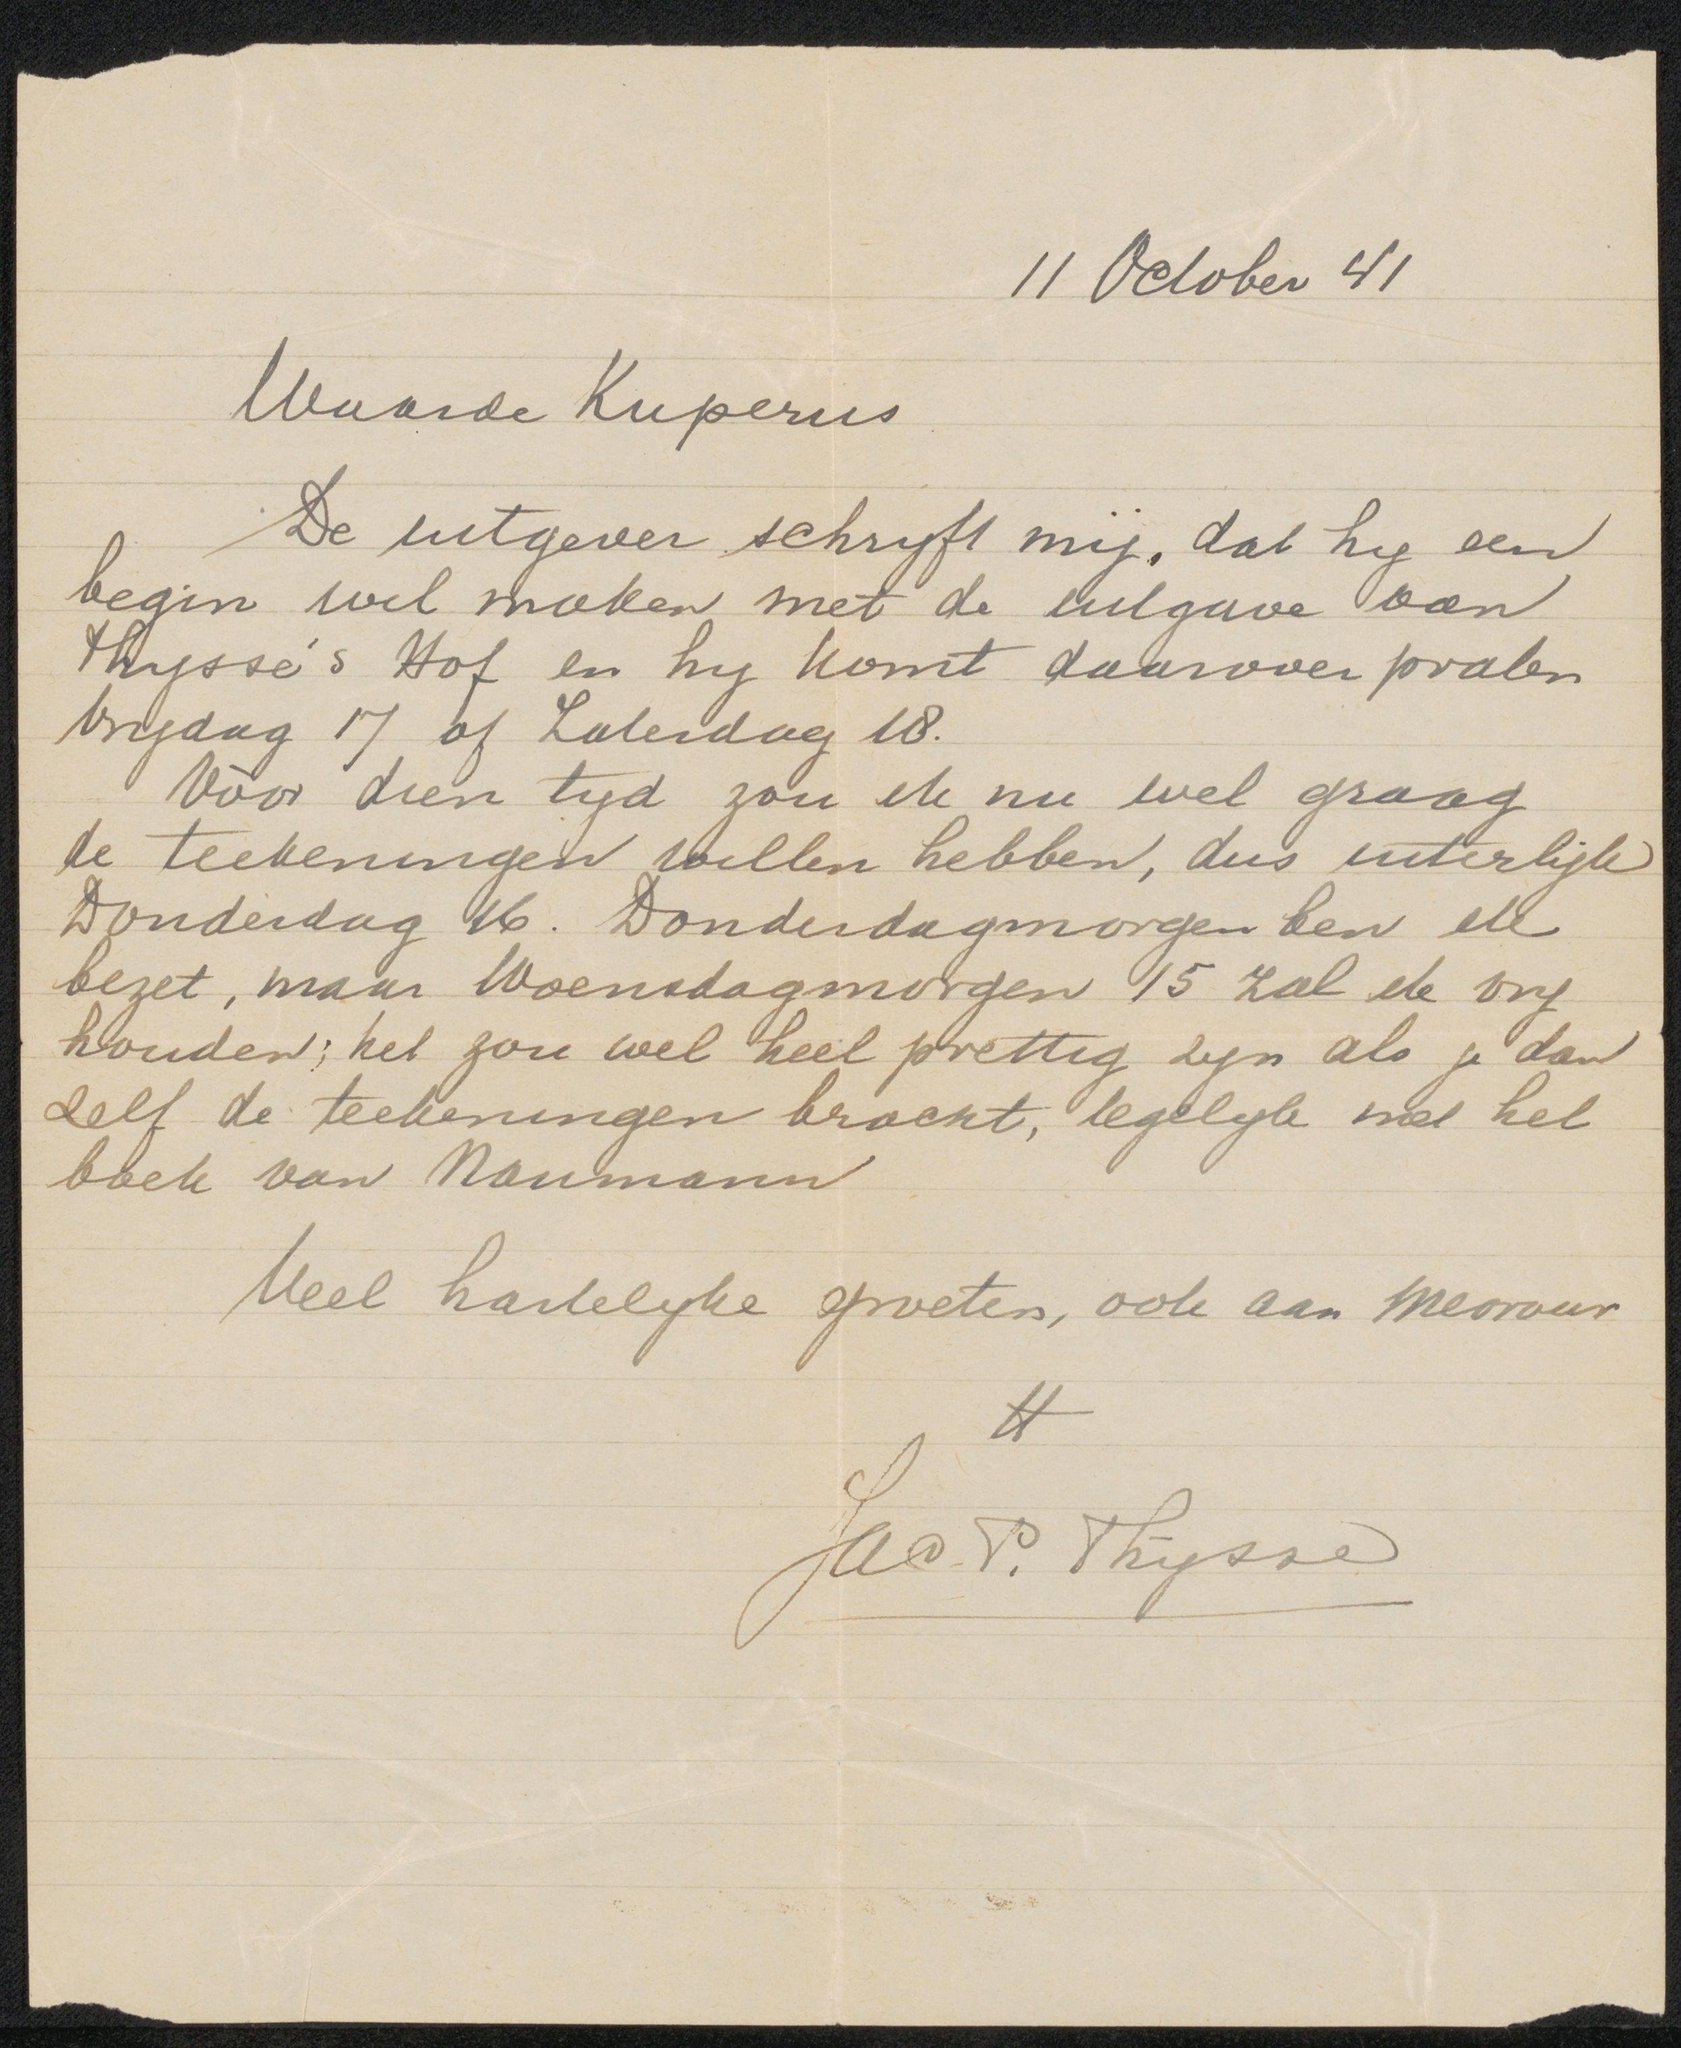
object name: letter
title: Brief aan Sjoerd Kuperus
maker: jac. p. thijsse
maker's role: bioloog, onderwijzer, schrijver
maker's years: 1865-1945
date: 1941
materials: ink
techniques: pen, writing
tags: print maker, draughtsman, sjoerd kuperus, illustration ~ printed matter, book, printed matter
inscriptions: collector's mark: ‘RPK’